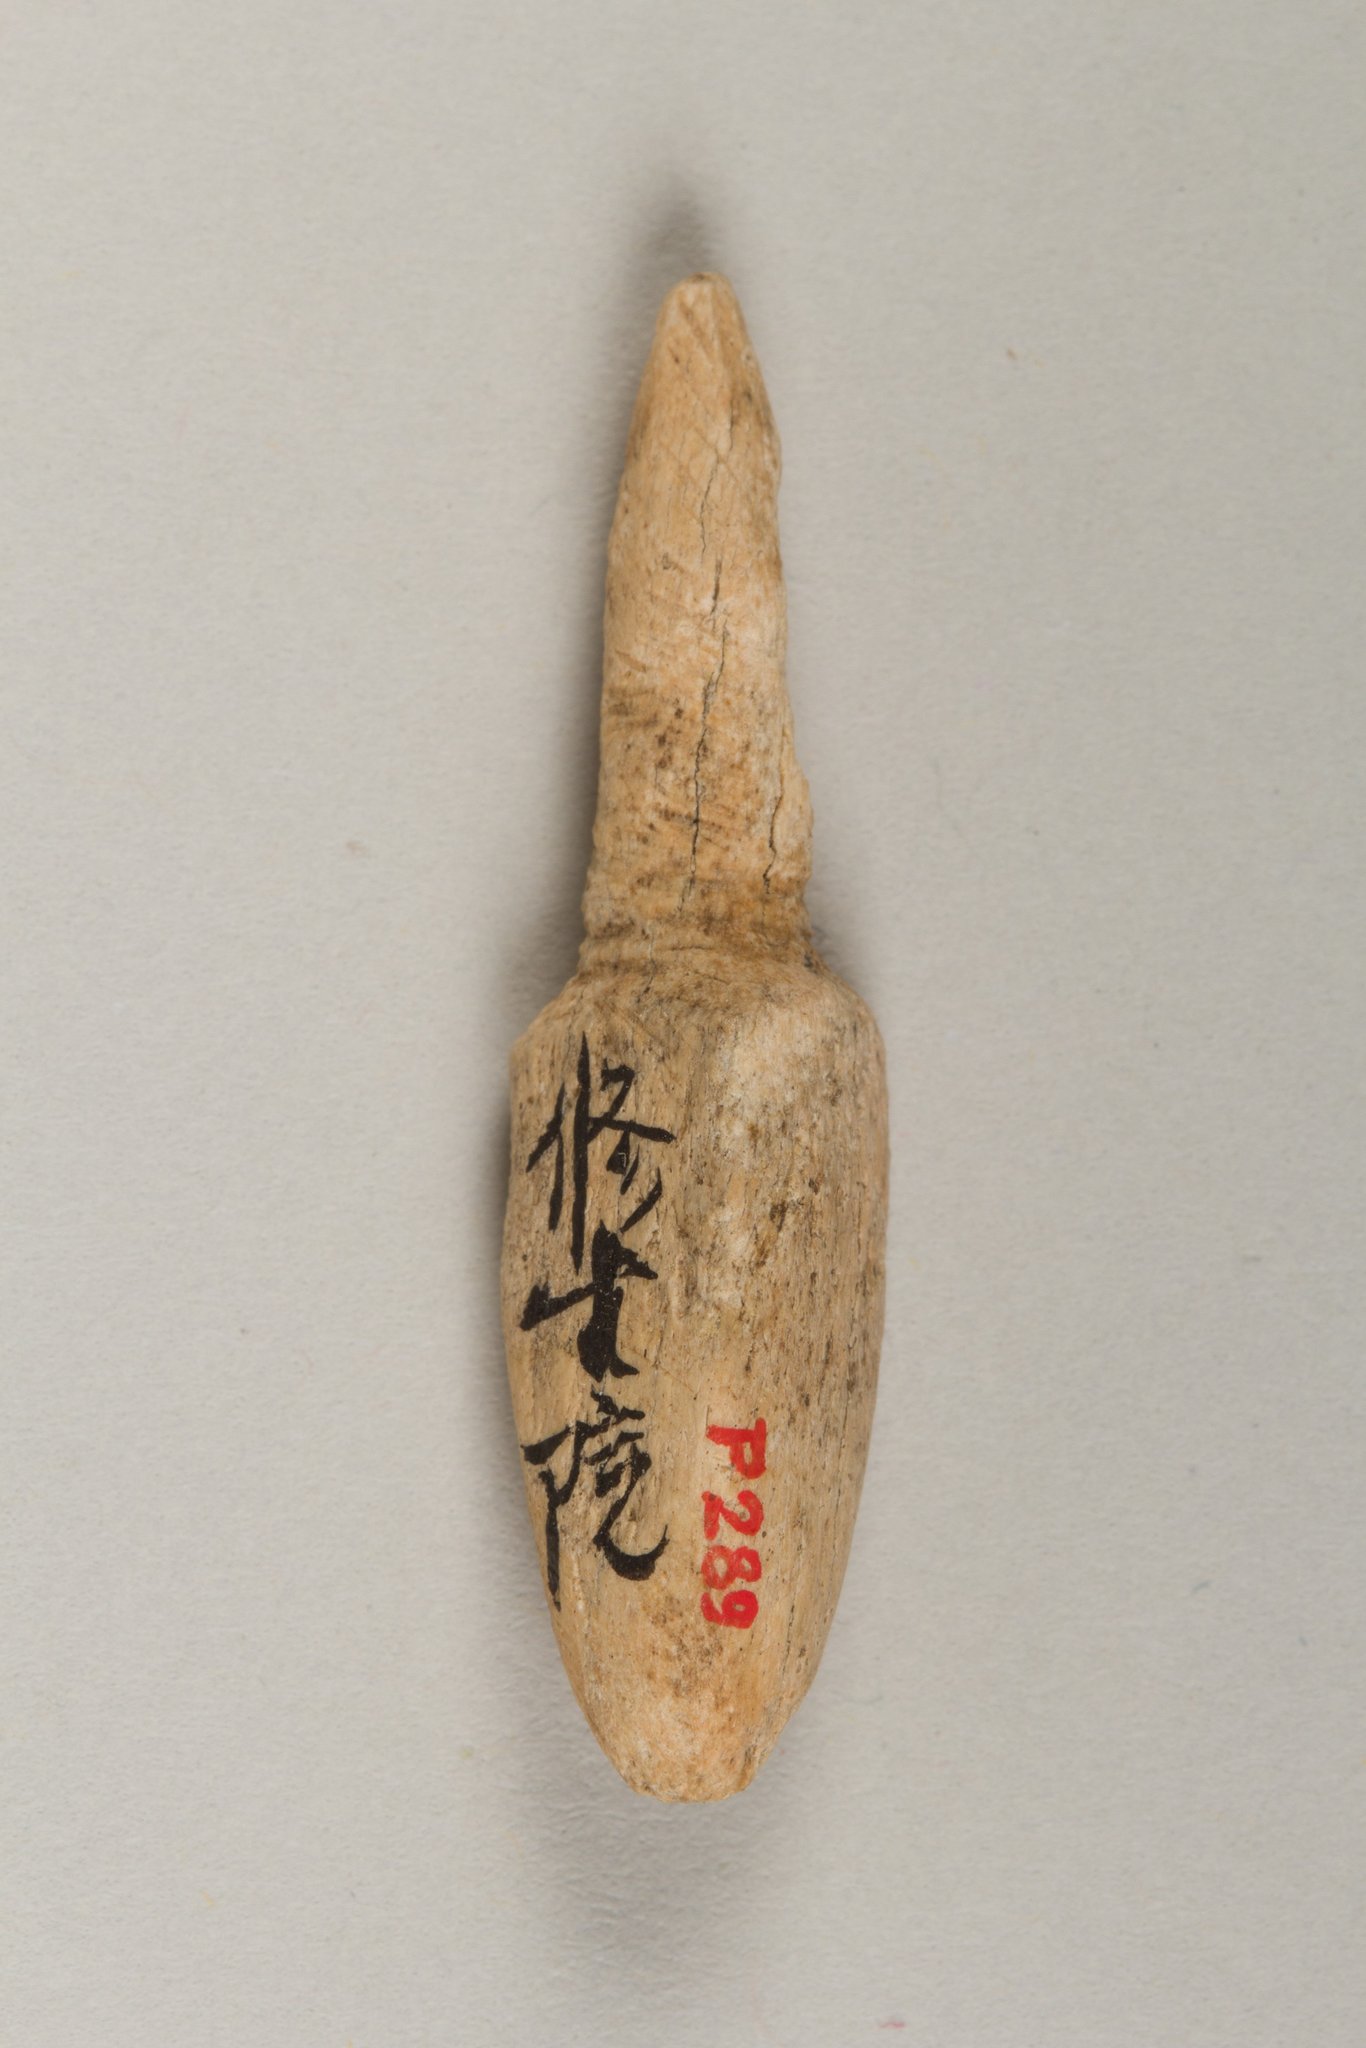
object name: arrowhead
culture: japanese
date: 1100-300 BCE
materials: bone